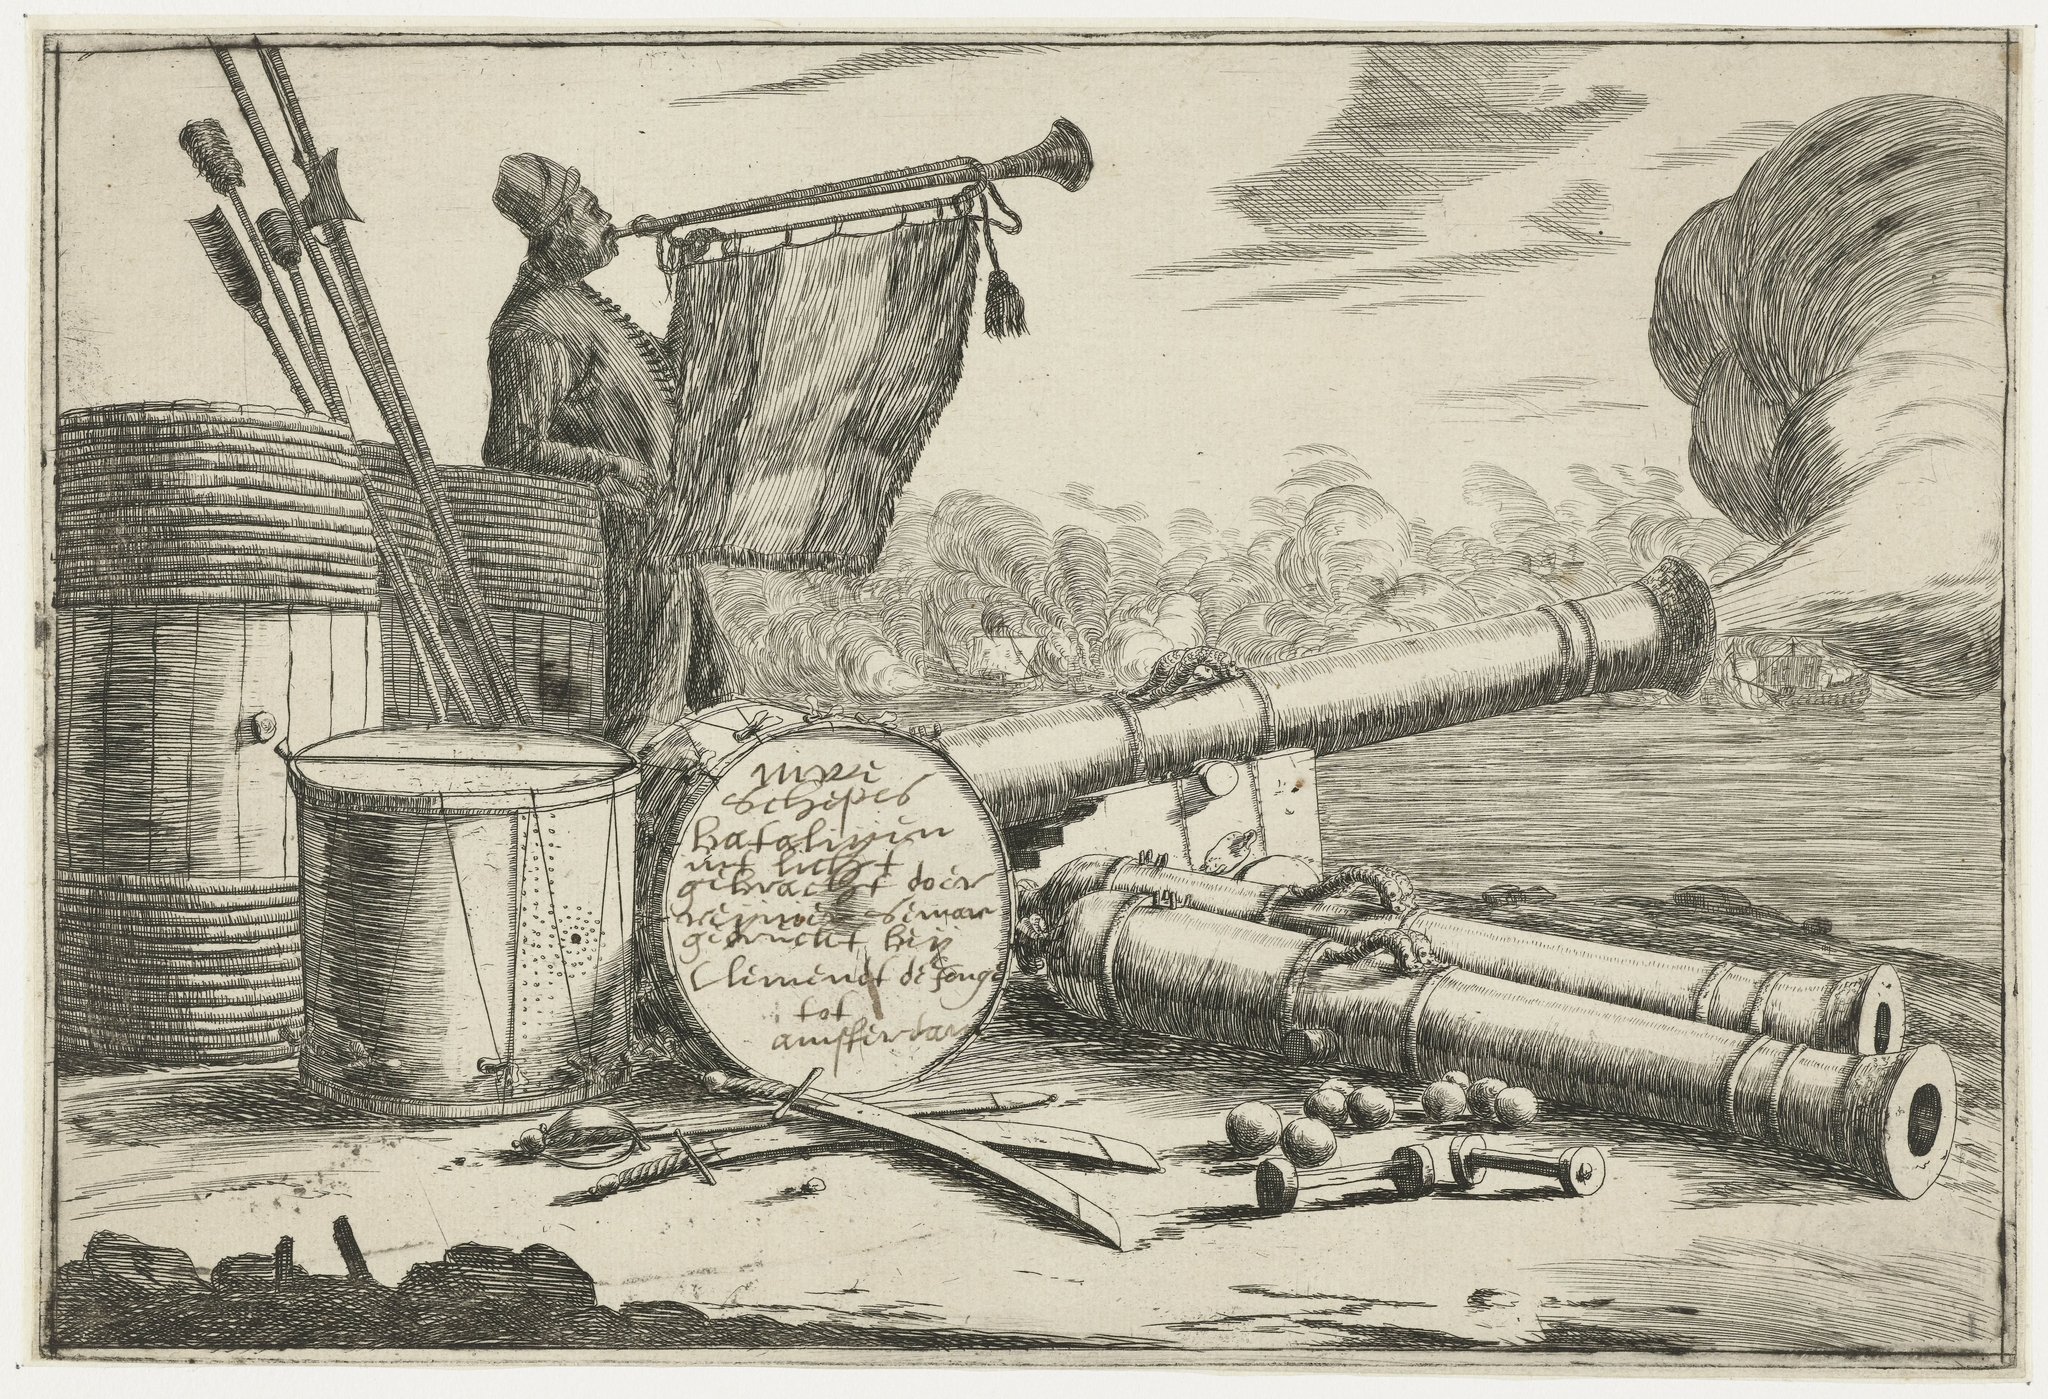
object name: titelprent, frontispice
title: Titelblad met de uitrusting van een oorlogsschip en een trompetspeler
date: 1652-1656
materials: paper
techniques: drypoint, etching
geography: netherlands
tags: title-page, warfare; military affairs (+ naval force)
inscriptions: inscription: ‘niuwe schepes Batalinien int licht gebracht doer reinier Seman gedruckt beij Clemendt de jonge tot amsterdam’, collector's mark: Lugt 240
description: Titelblad voor een reeks van zeeslagen. De uitrusting van een oorlogsschip waaronder kanonnen, kogels, kruitvaten en een trom waarop de titel van de serie met pen is geschreven in een zeventiende-eeuws handschrift. Een zeeman blaast op een trompet waaraan een vlag hangt.